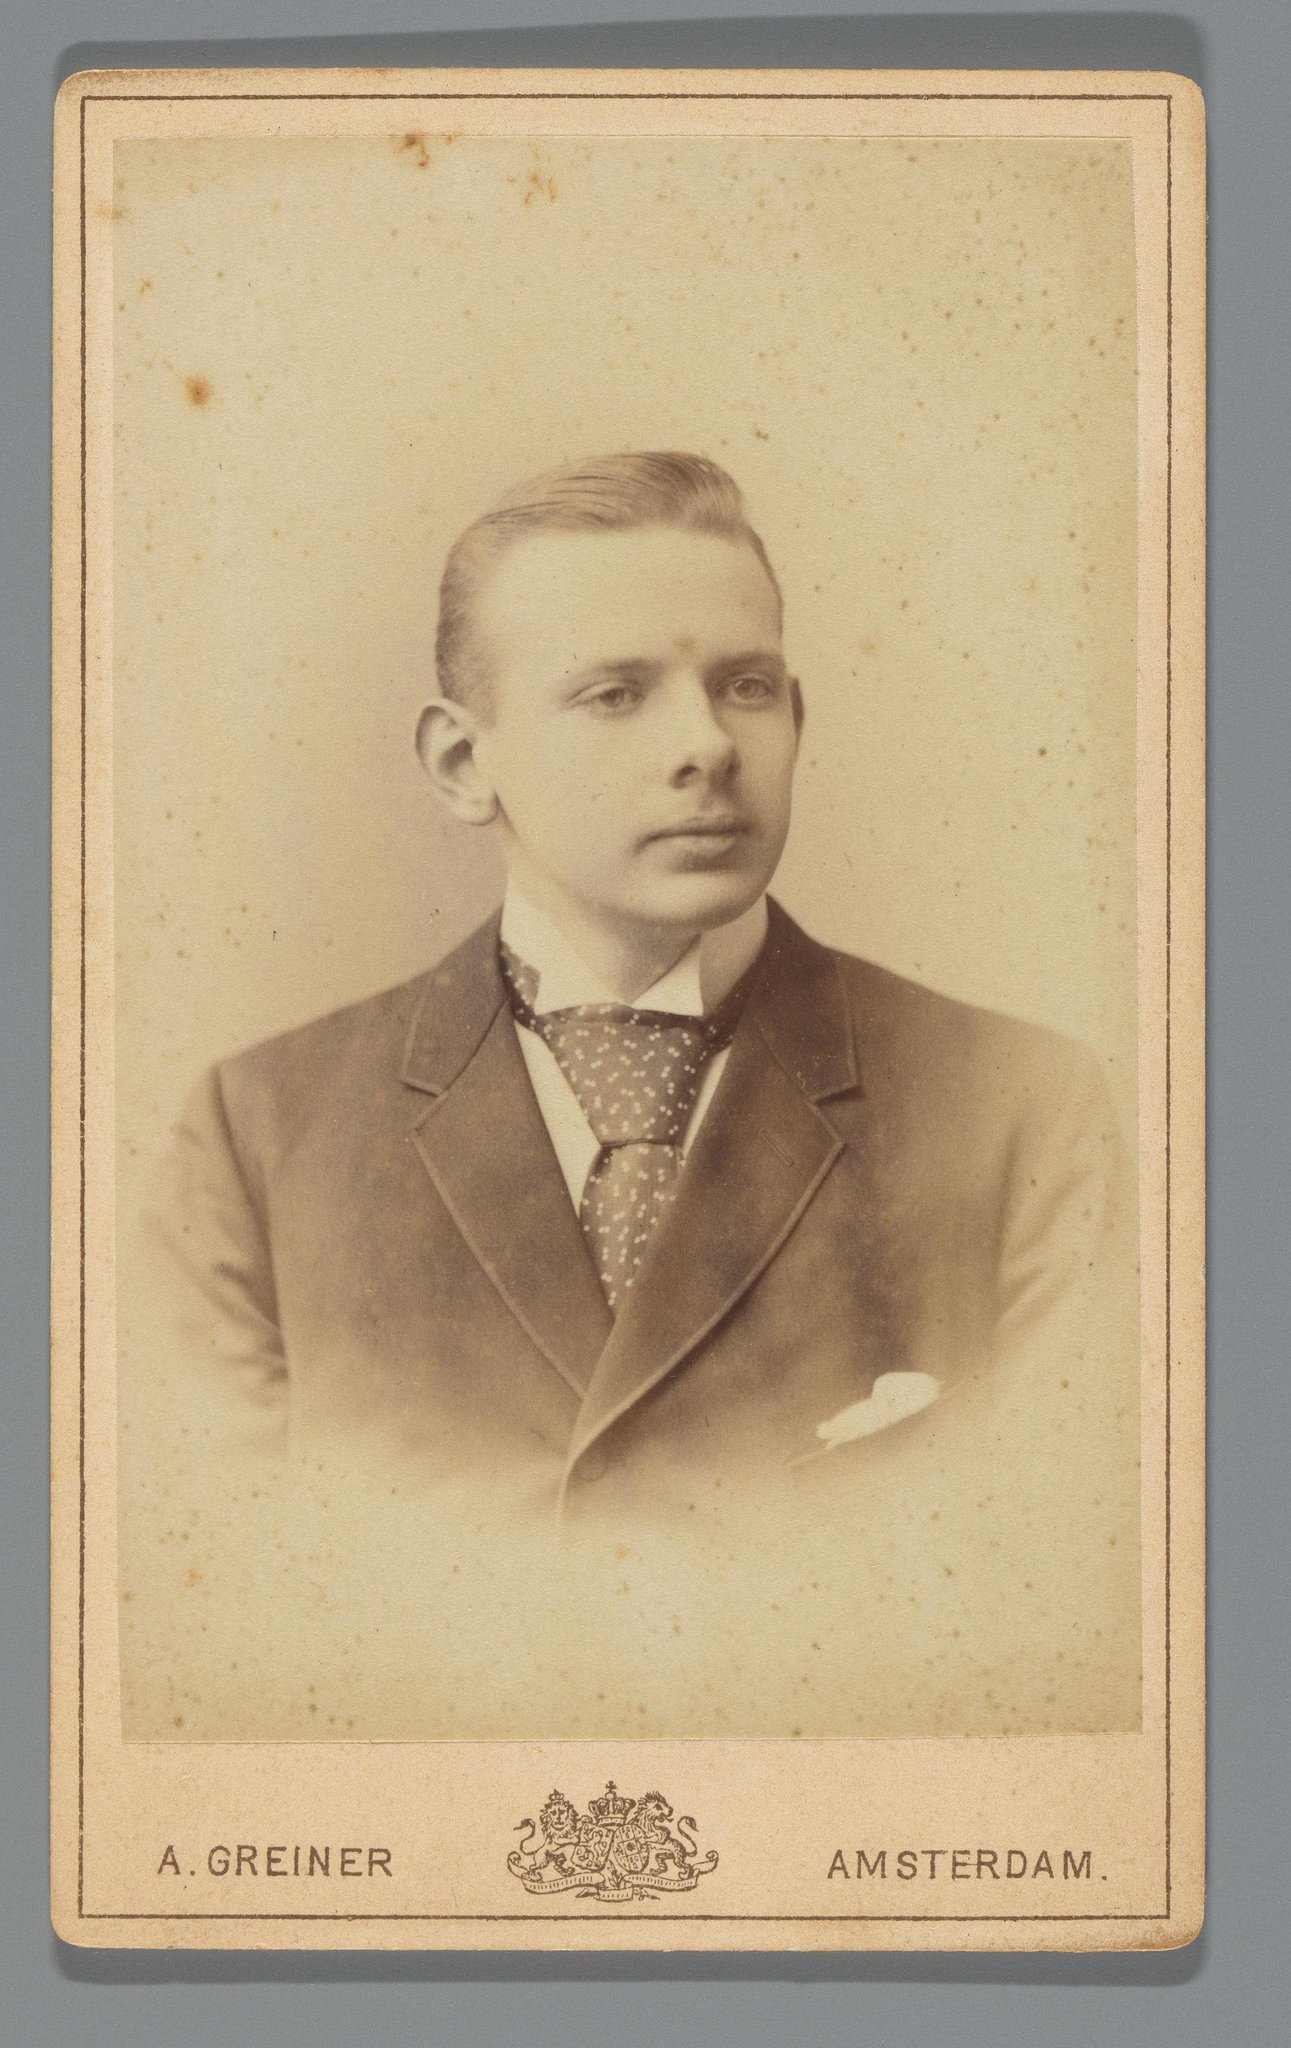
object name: photograph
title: Portret van Karel Frederik van den Berg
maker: albert greiner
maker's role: fotograaf, fotostudio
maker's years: 1833-1890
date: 1895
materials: cardboard, photographic support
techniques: albumen print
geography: amsterdam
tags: batavia, karel frederik van den berg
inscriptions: name: ‘ALBERT GREINER / AMSTERDAM / NIEUWENDIJK 89, / Specialiteit in Vergrootingen.’, name: ‘K.F. van den Berg’, name: ‘A. GREINER AMSTERDAM.’